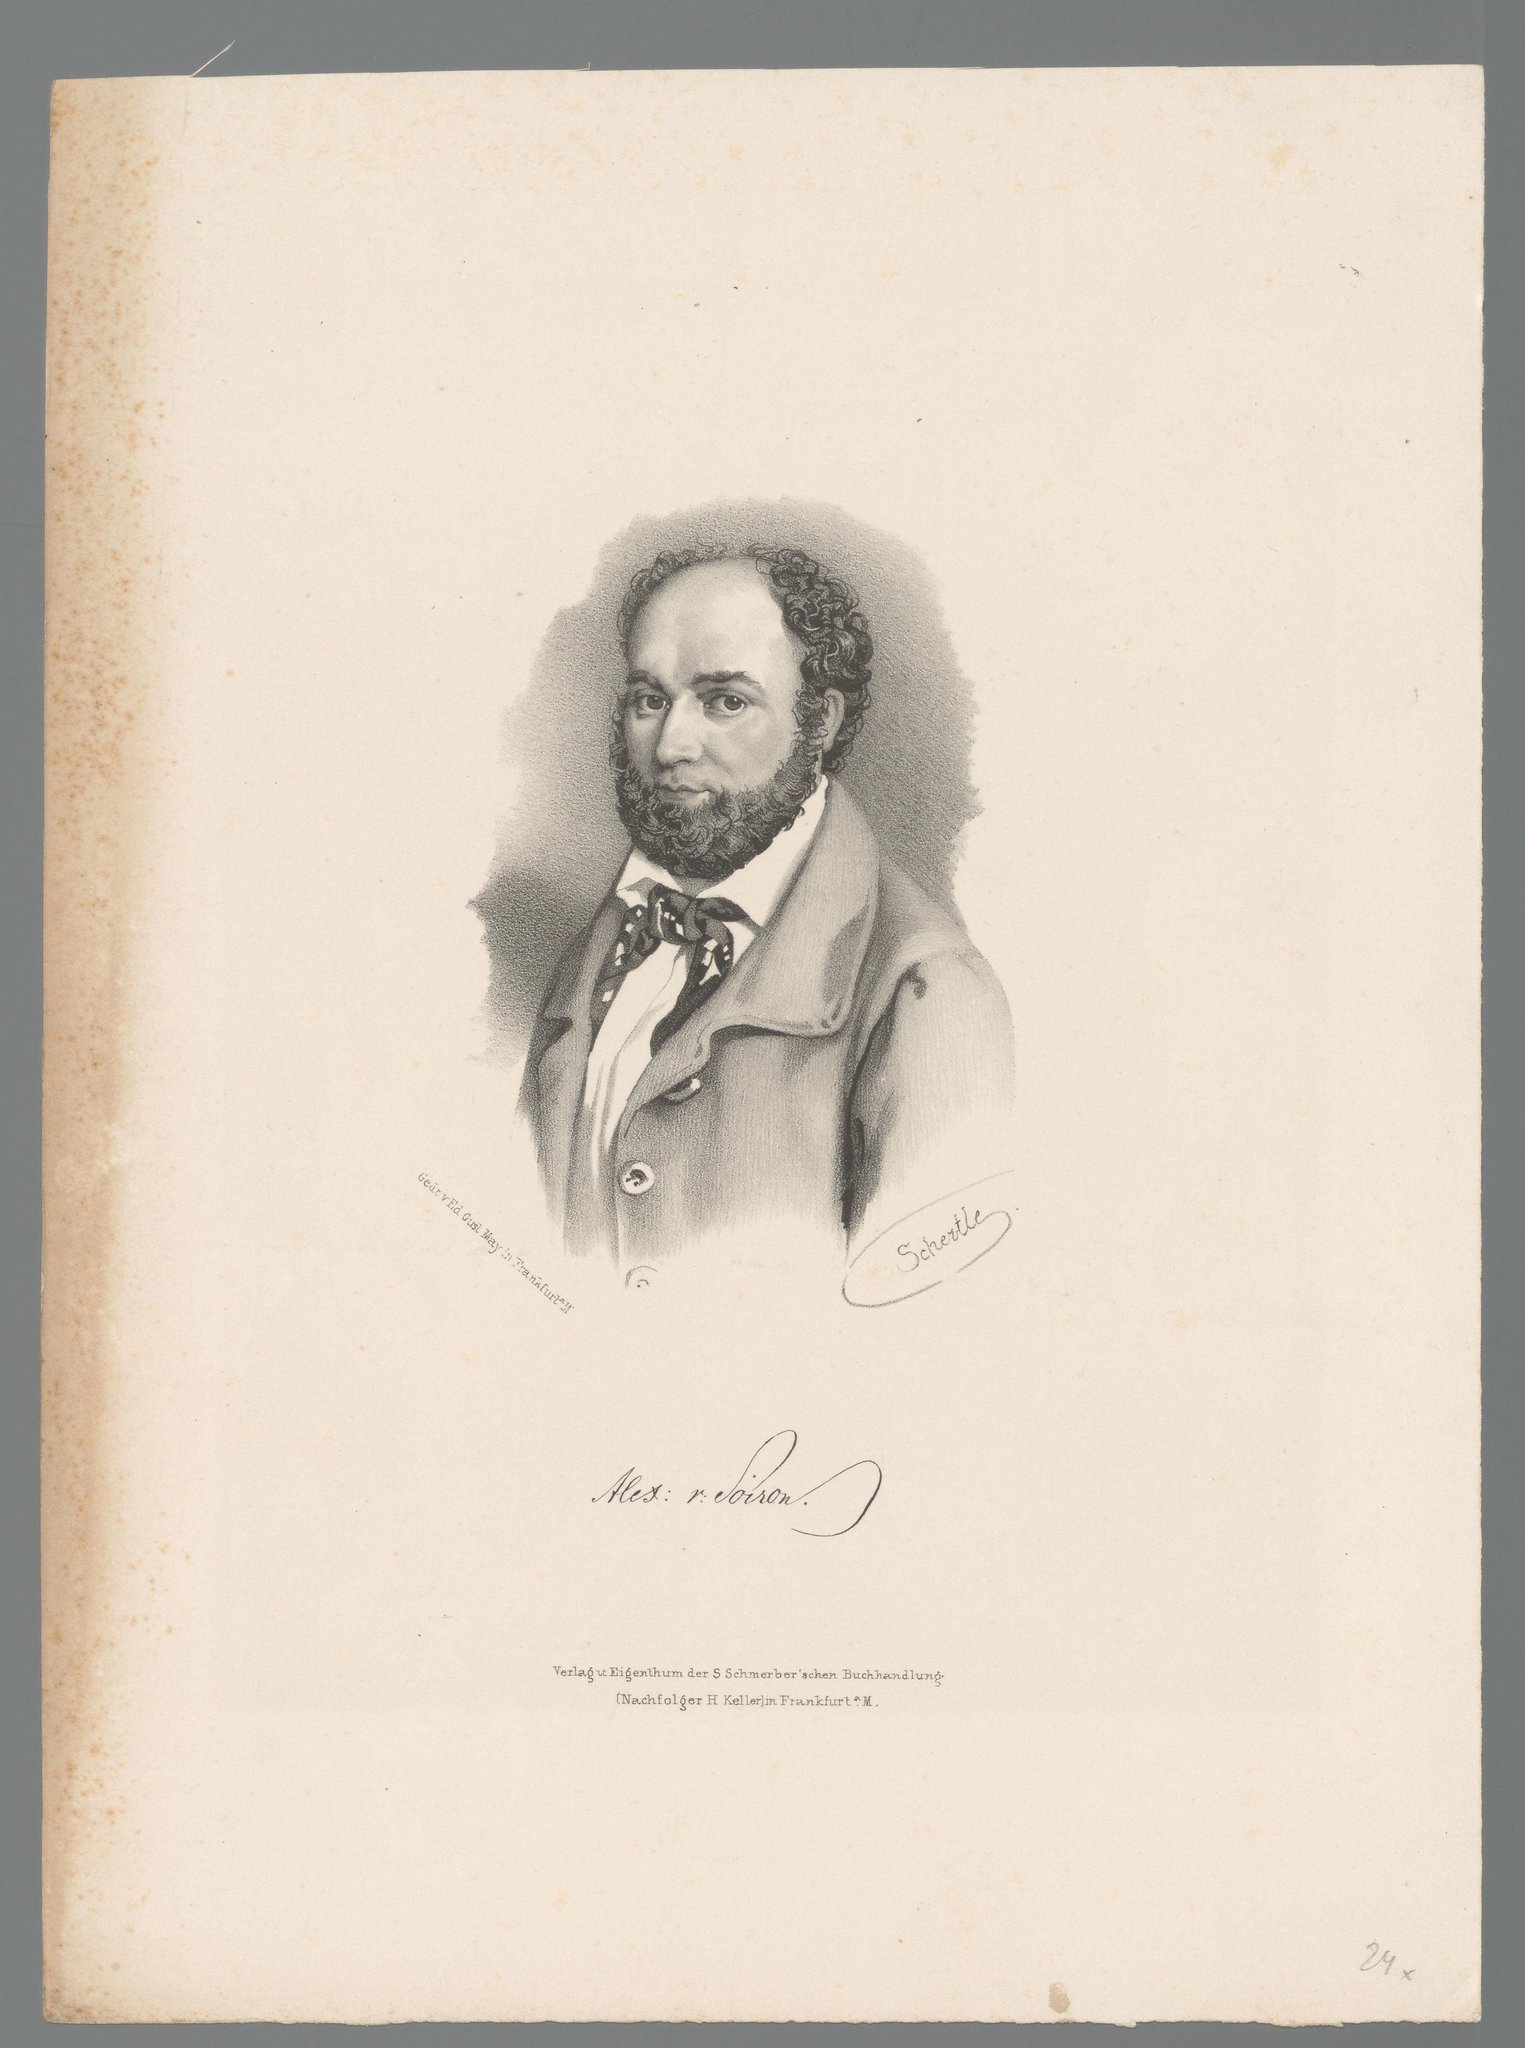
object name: print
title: Portretten van Duitse mannen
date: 1848-1849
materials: paper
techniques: lithograph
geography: frankfurt am main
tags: adult man, historical persons, beard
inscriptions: collector's mark: Lugt 2228